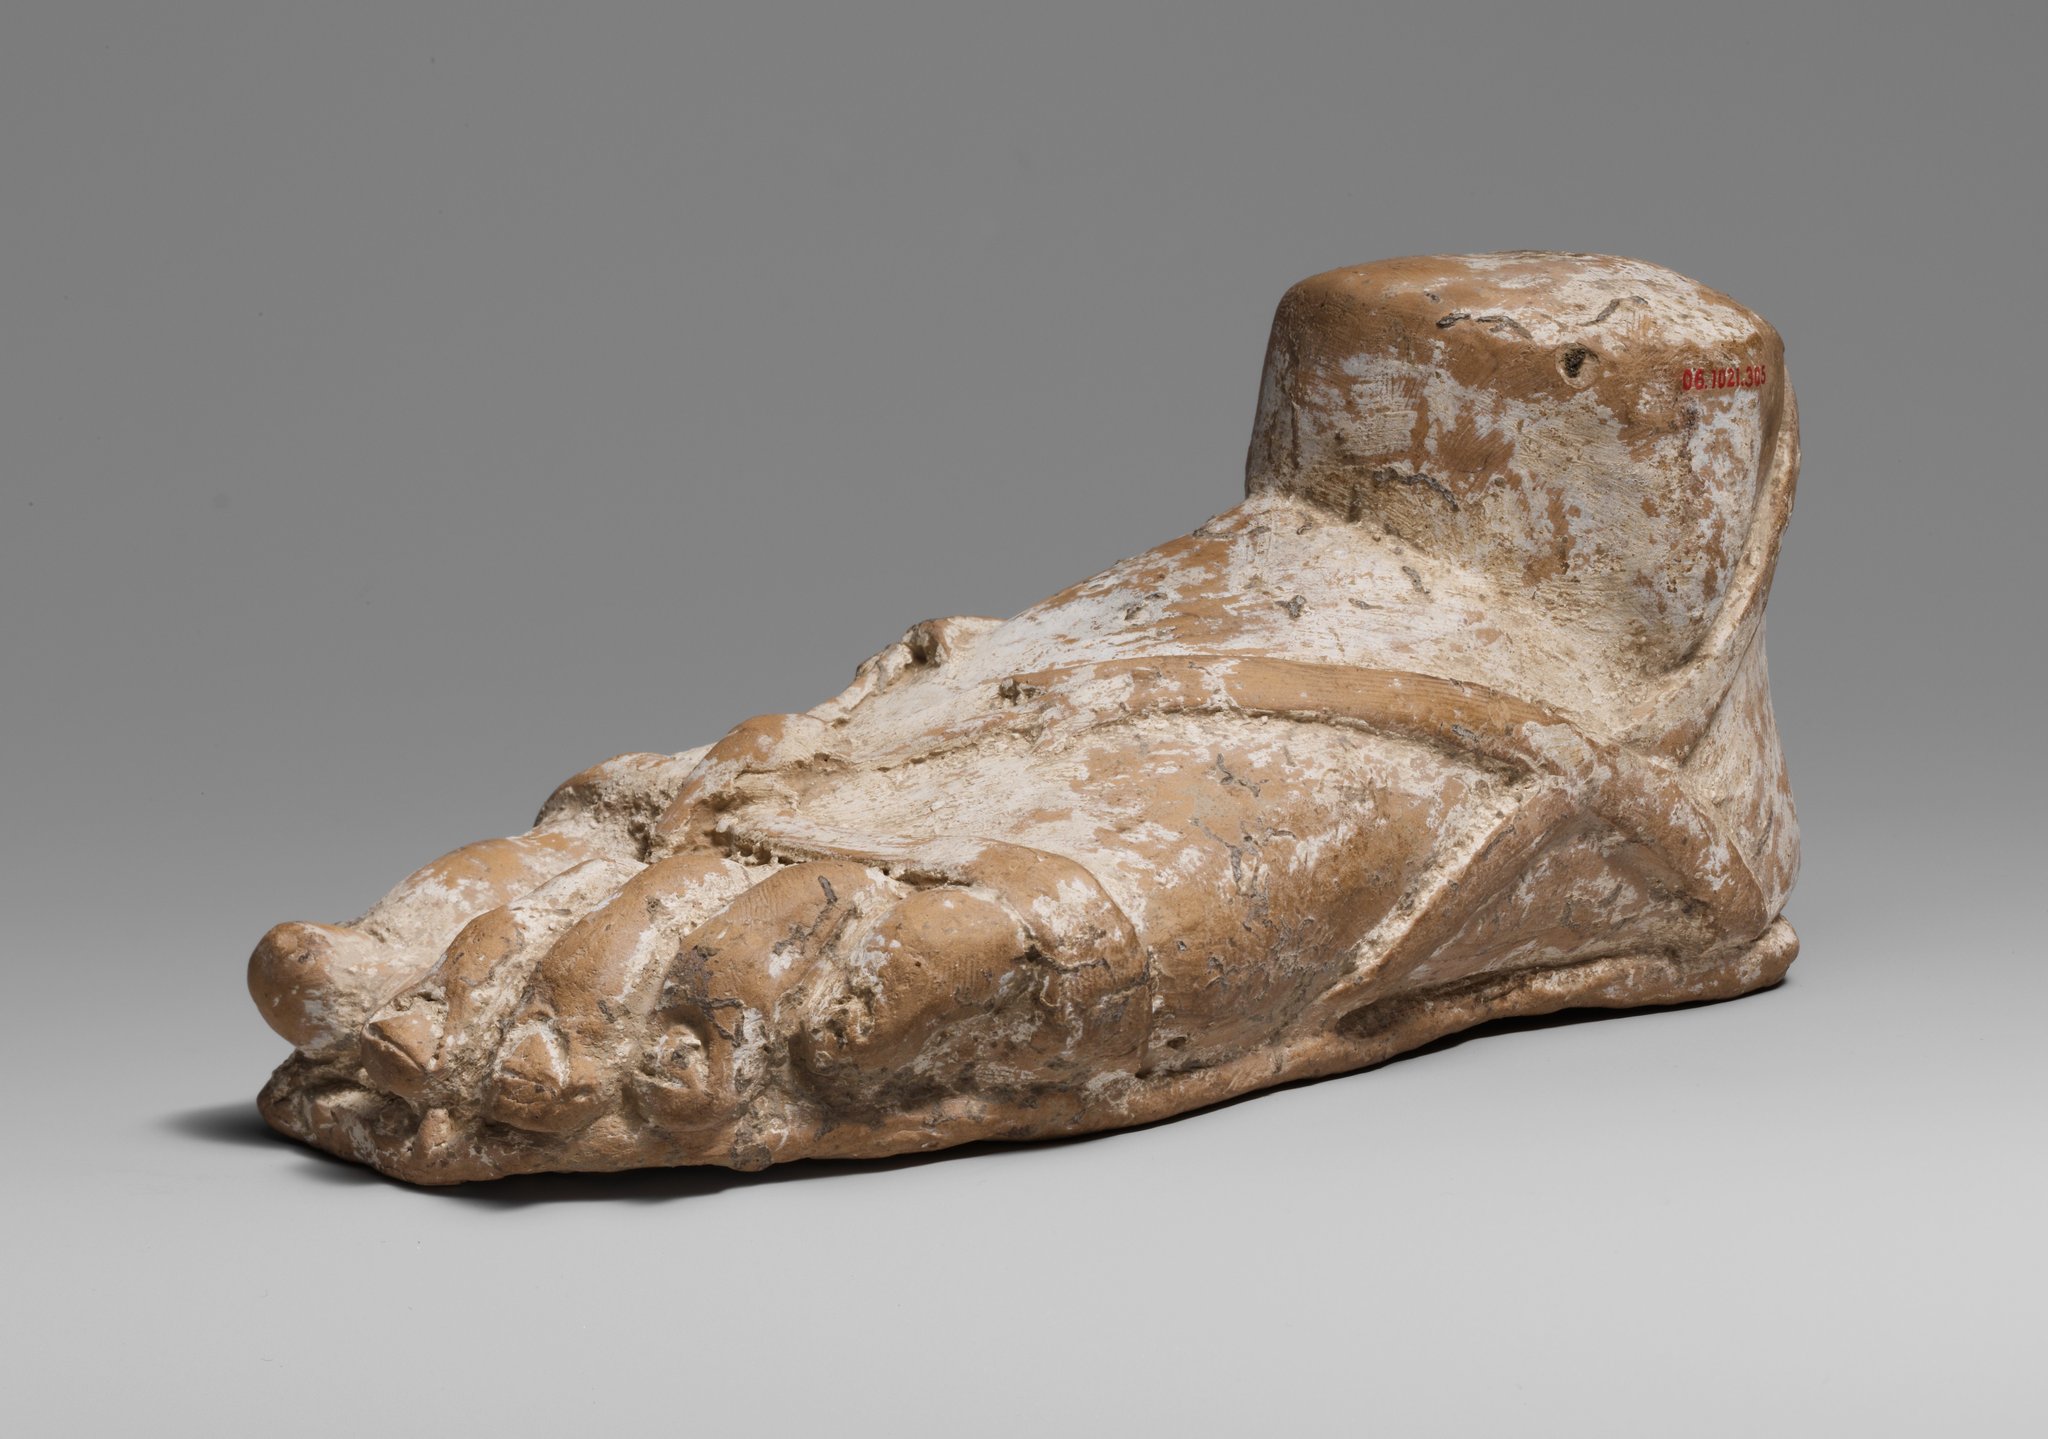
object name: left foot and ankle with sandal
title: Terracotta left foot and ankle with sandal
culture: greek or south italian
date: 350-301 BCE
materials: terracotta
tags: feet